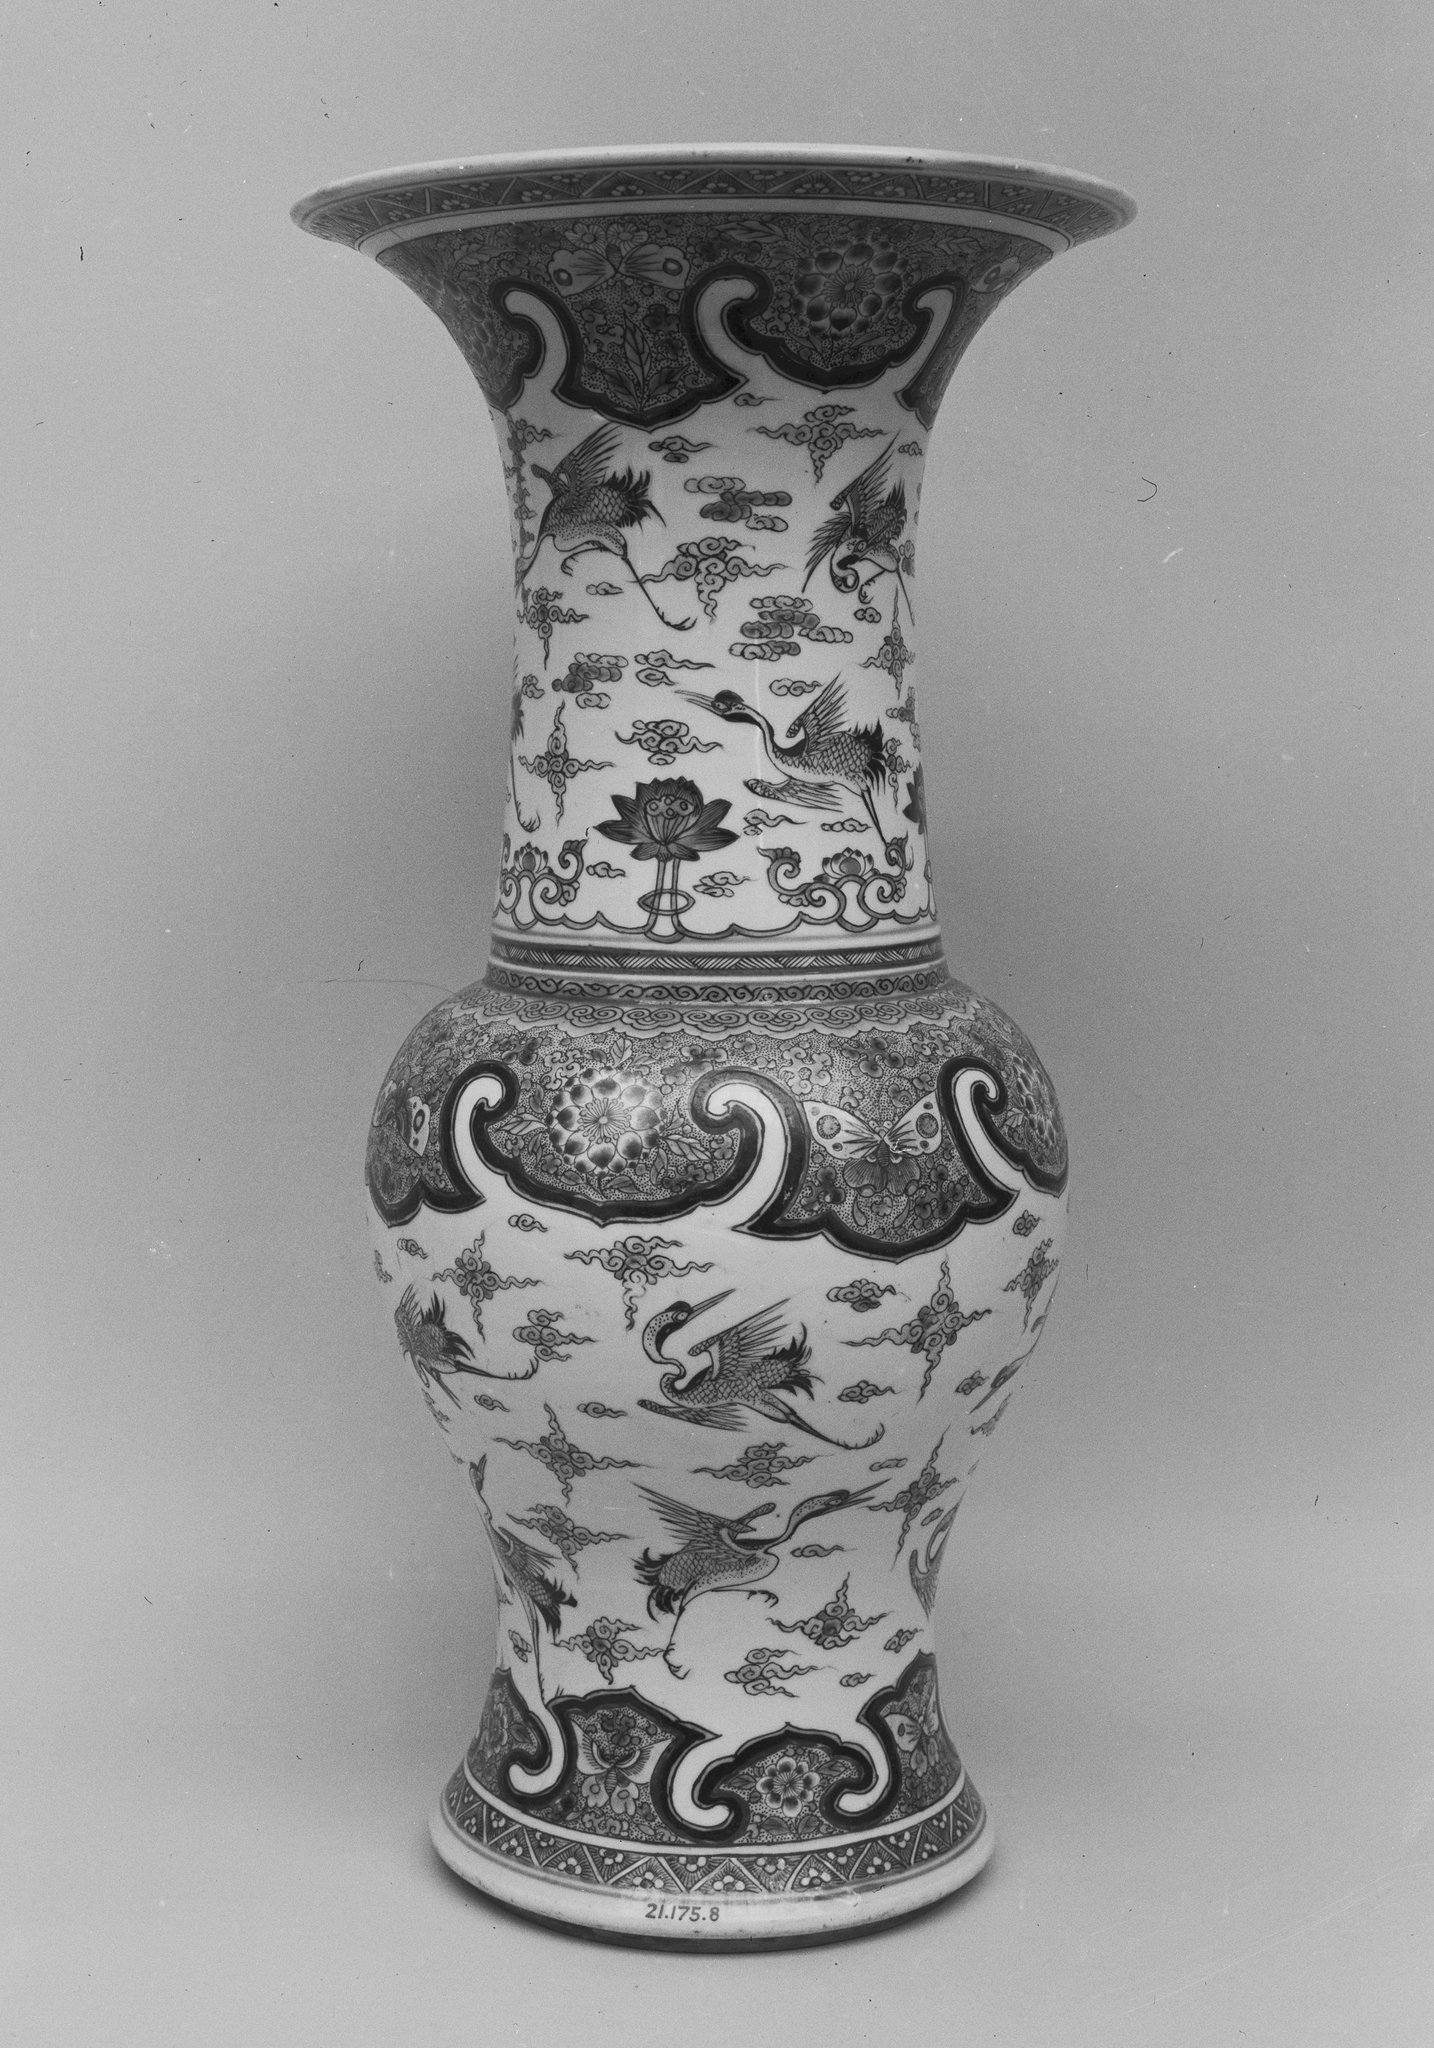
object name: vase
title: Vase decorated with cranes amid clouds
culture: chinese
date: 1662-1722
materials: enamel, porcelain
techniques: overglaze, painting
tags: birds,flowers